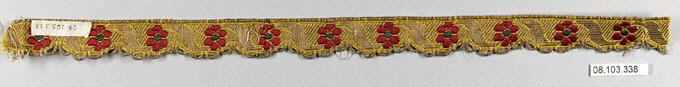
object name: galloon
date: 1801-1900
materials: metal thread, silk